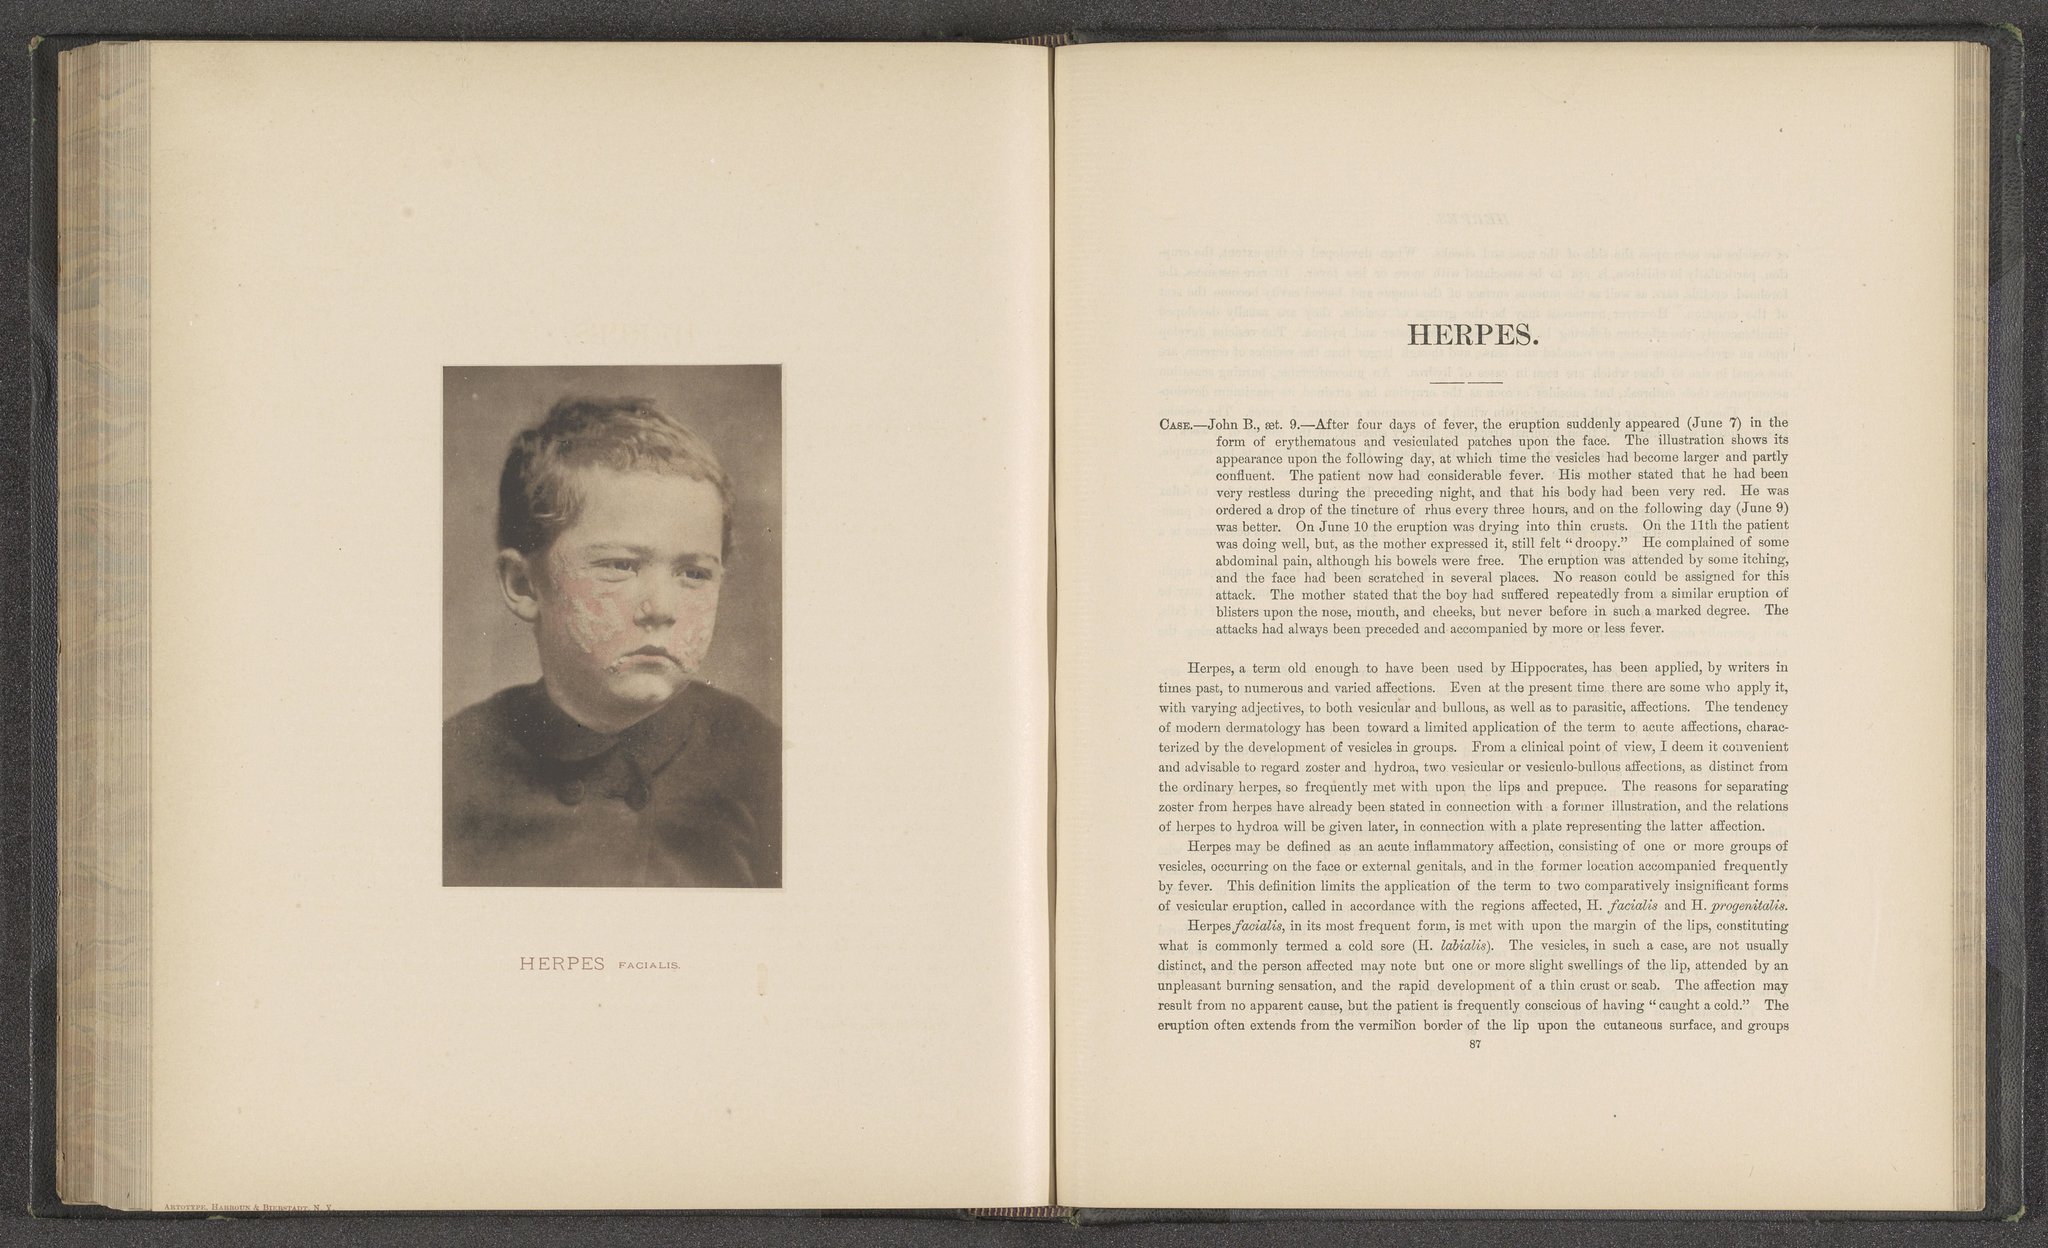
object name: page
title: Herpes facialis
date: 1870-1881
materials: paper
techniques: photograph, hand coloring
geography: new york city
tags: face, skin and venereal diseases